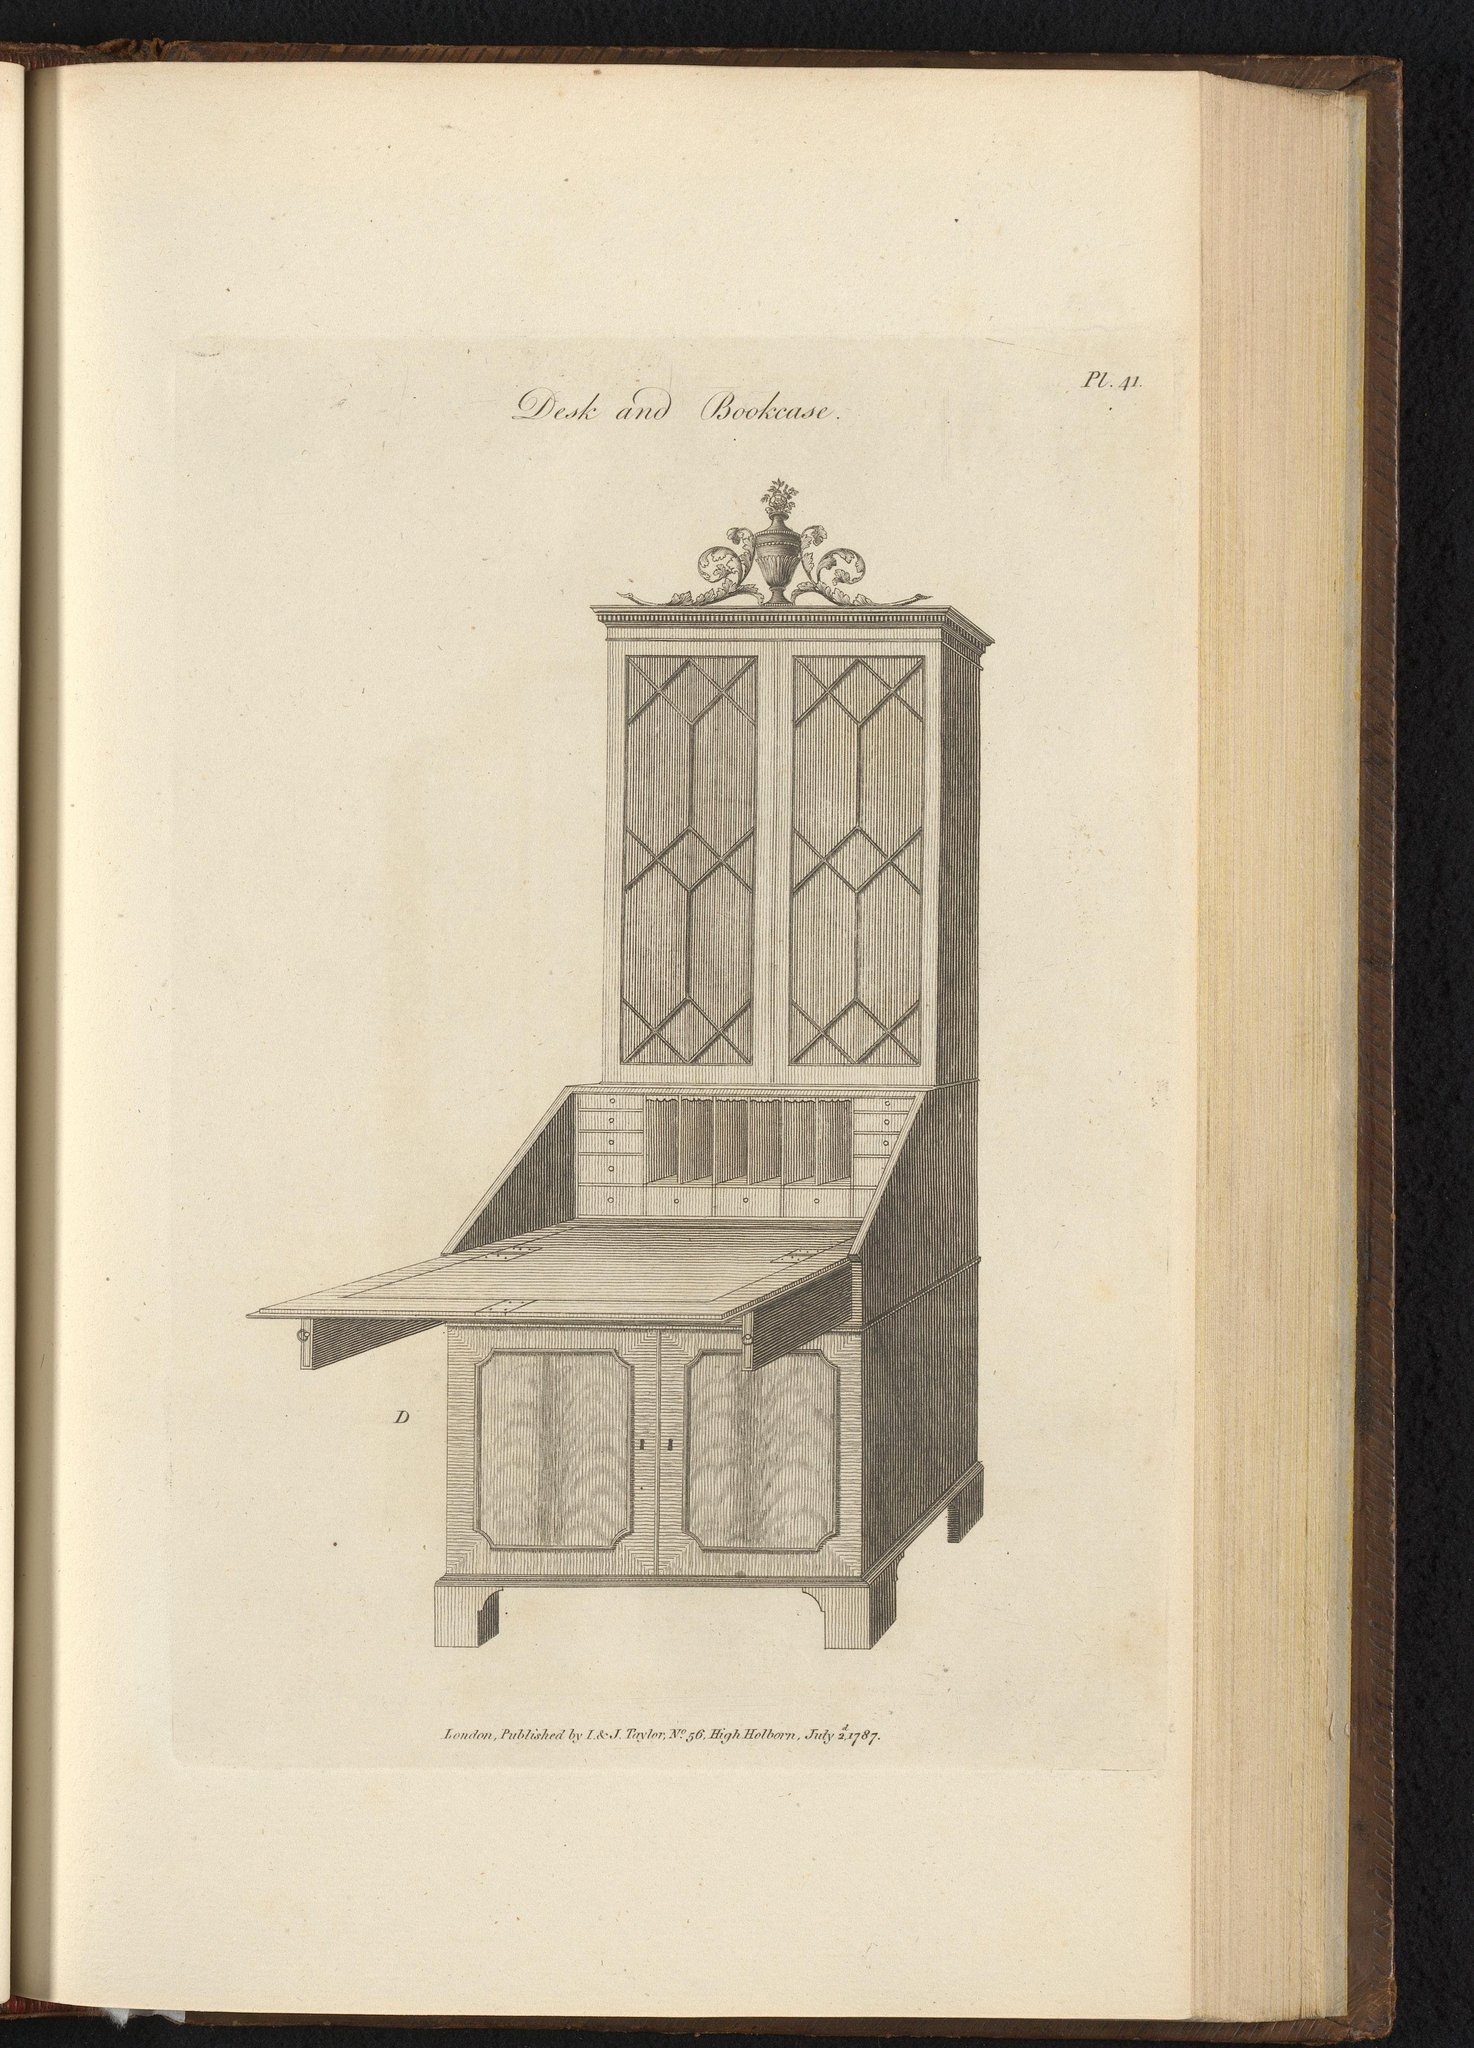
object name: page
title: Secretaire met boekenkast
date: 1787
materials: paper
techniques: engraving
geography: holborn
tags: bookcase, with doors, table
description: Genummerd: Pl. 41. Prent maakt deel uit van een boek.